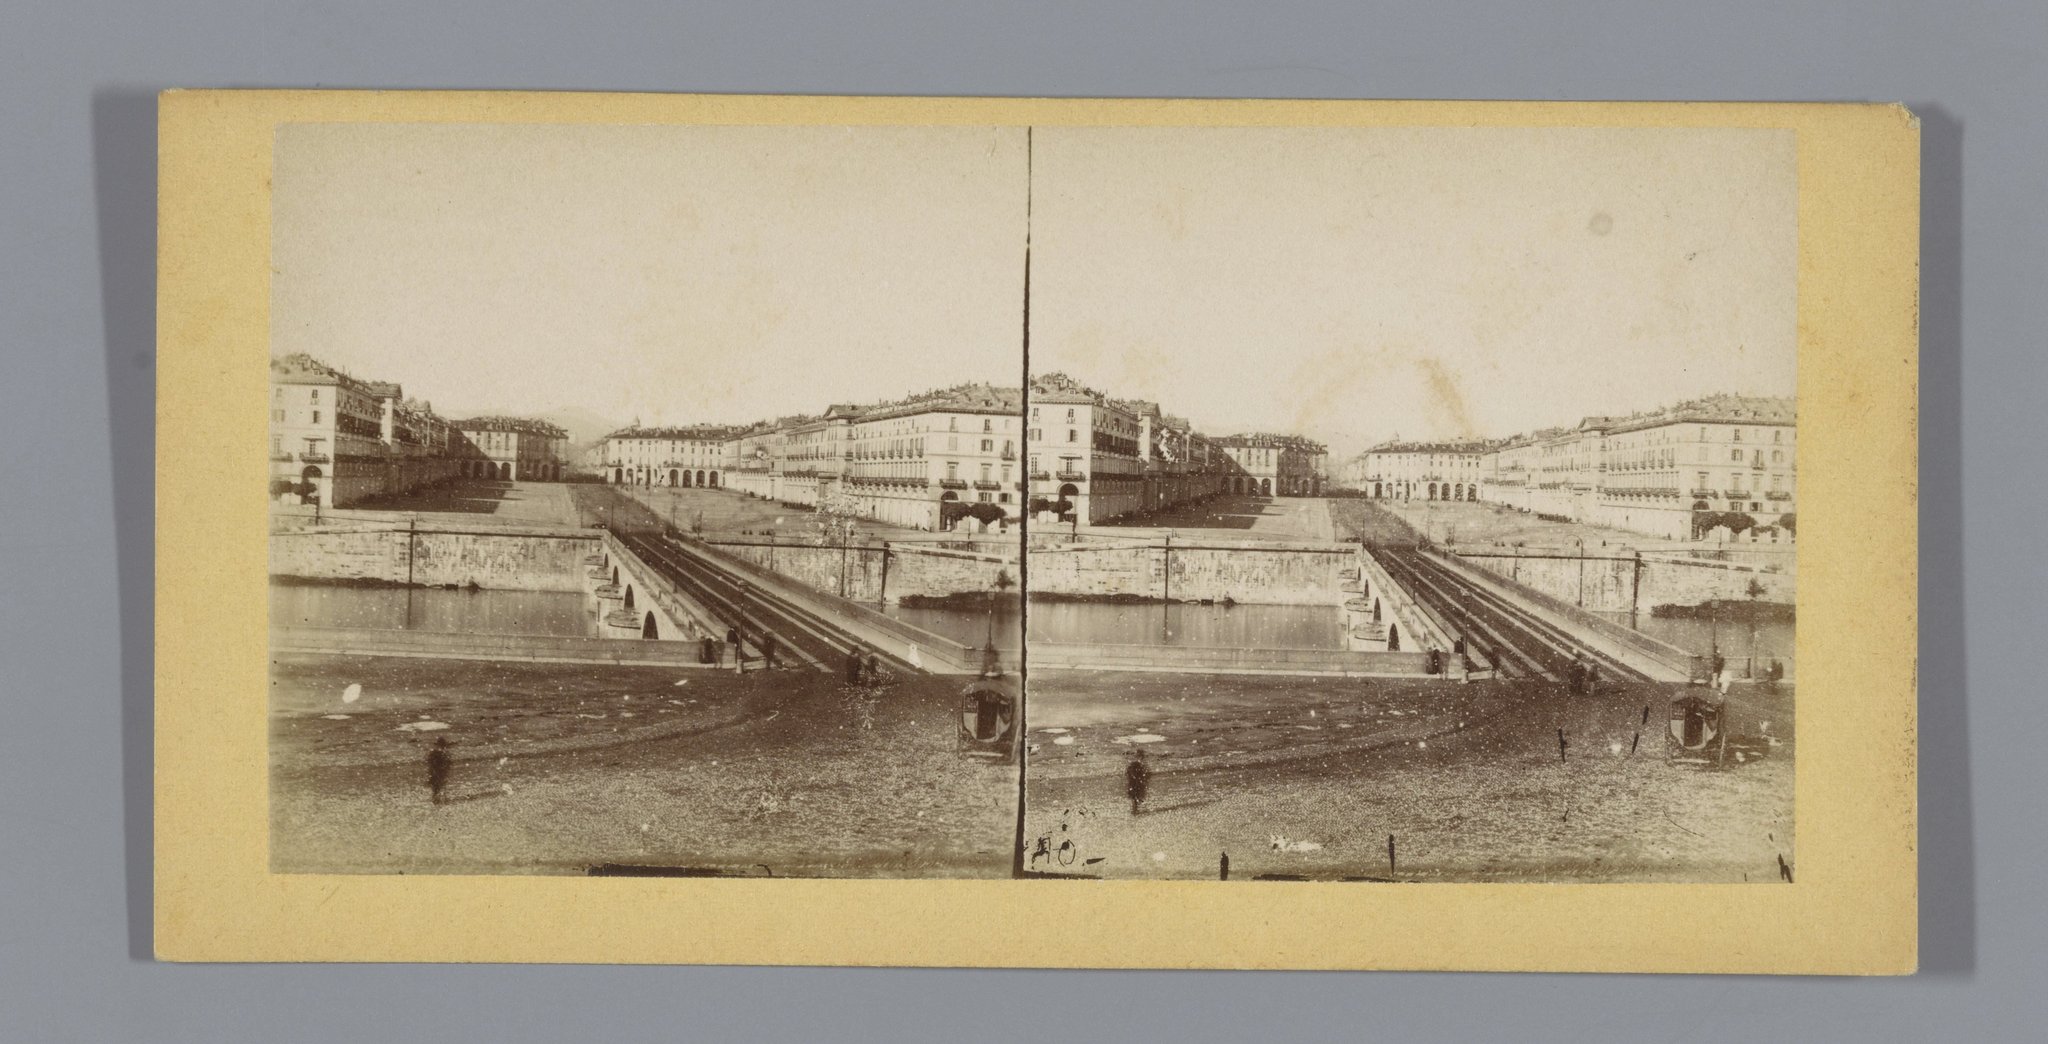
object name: stereograph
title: Ponte Vittorio Emanuele I te Turijn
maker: Anonymous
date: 1850-1880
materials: cardboard, photographic support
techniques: albumen print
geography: turin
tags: façade (of house or building), bridge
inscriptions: inscription: ‘Turin’